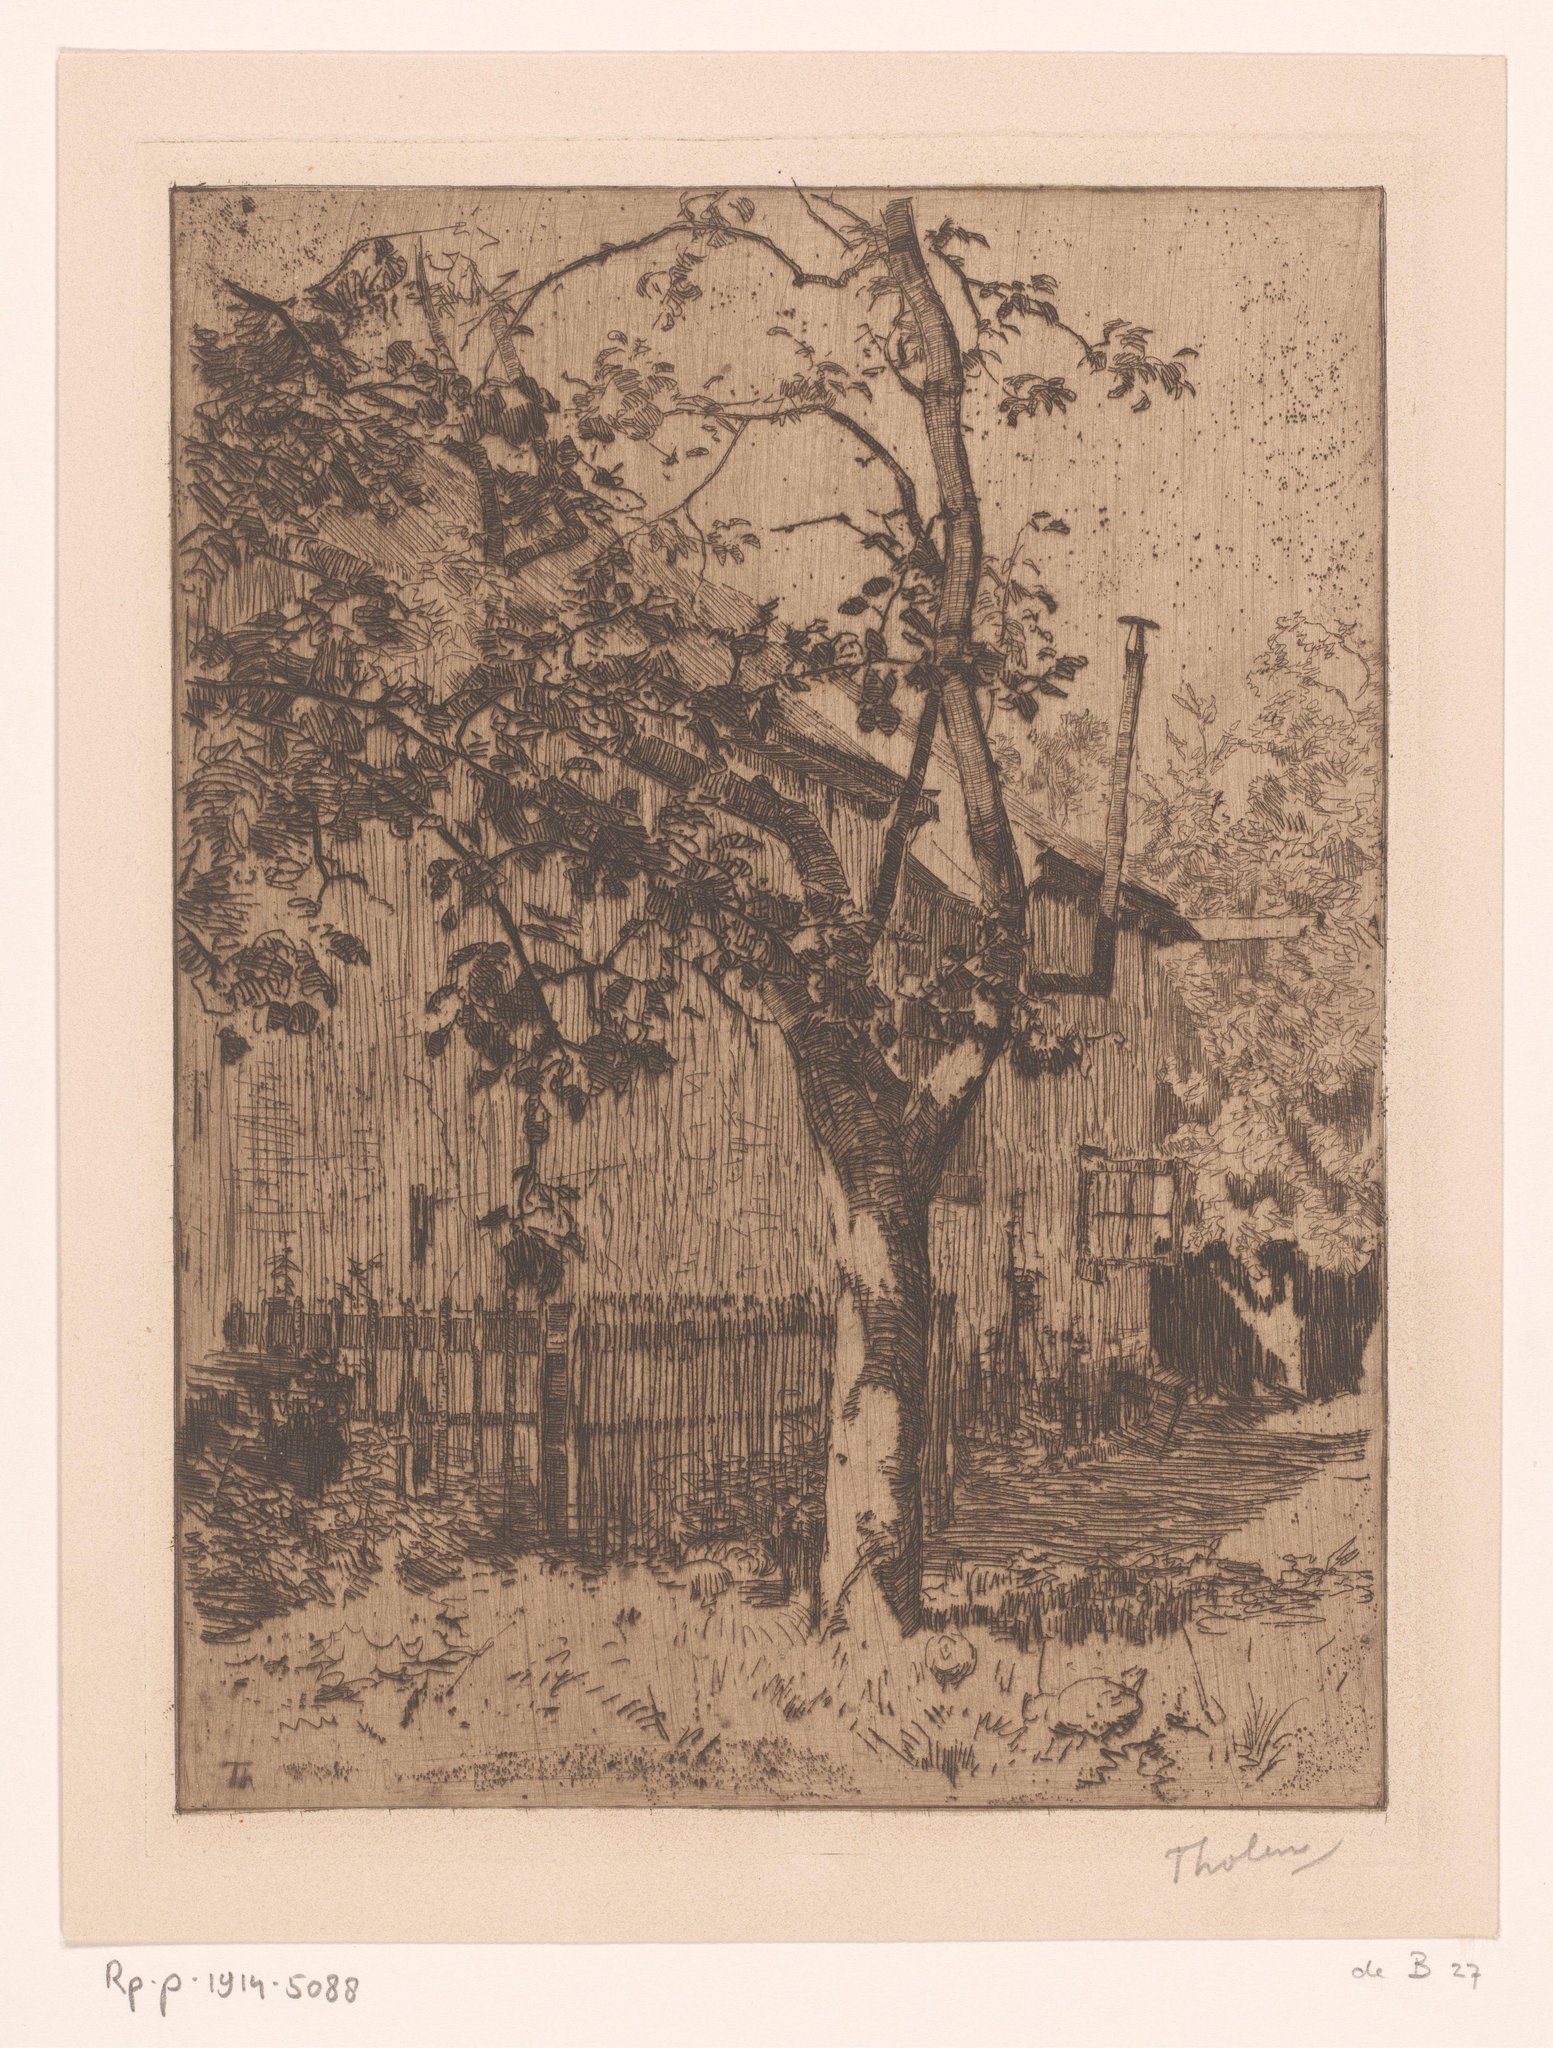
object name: print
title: Atelier, Ewijkshoeve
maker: willem bastiaan tholen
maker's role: draughtsman, painter, print maker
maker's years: 1860-1931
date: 1870-1914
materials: paper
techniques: drypoint, etching, intaglio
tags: rural housing, e.g. country-house, villa, cottage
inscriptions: collector's mark: Lugt 2233